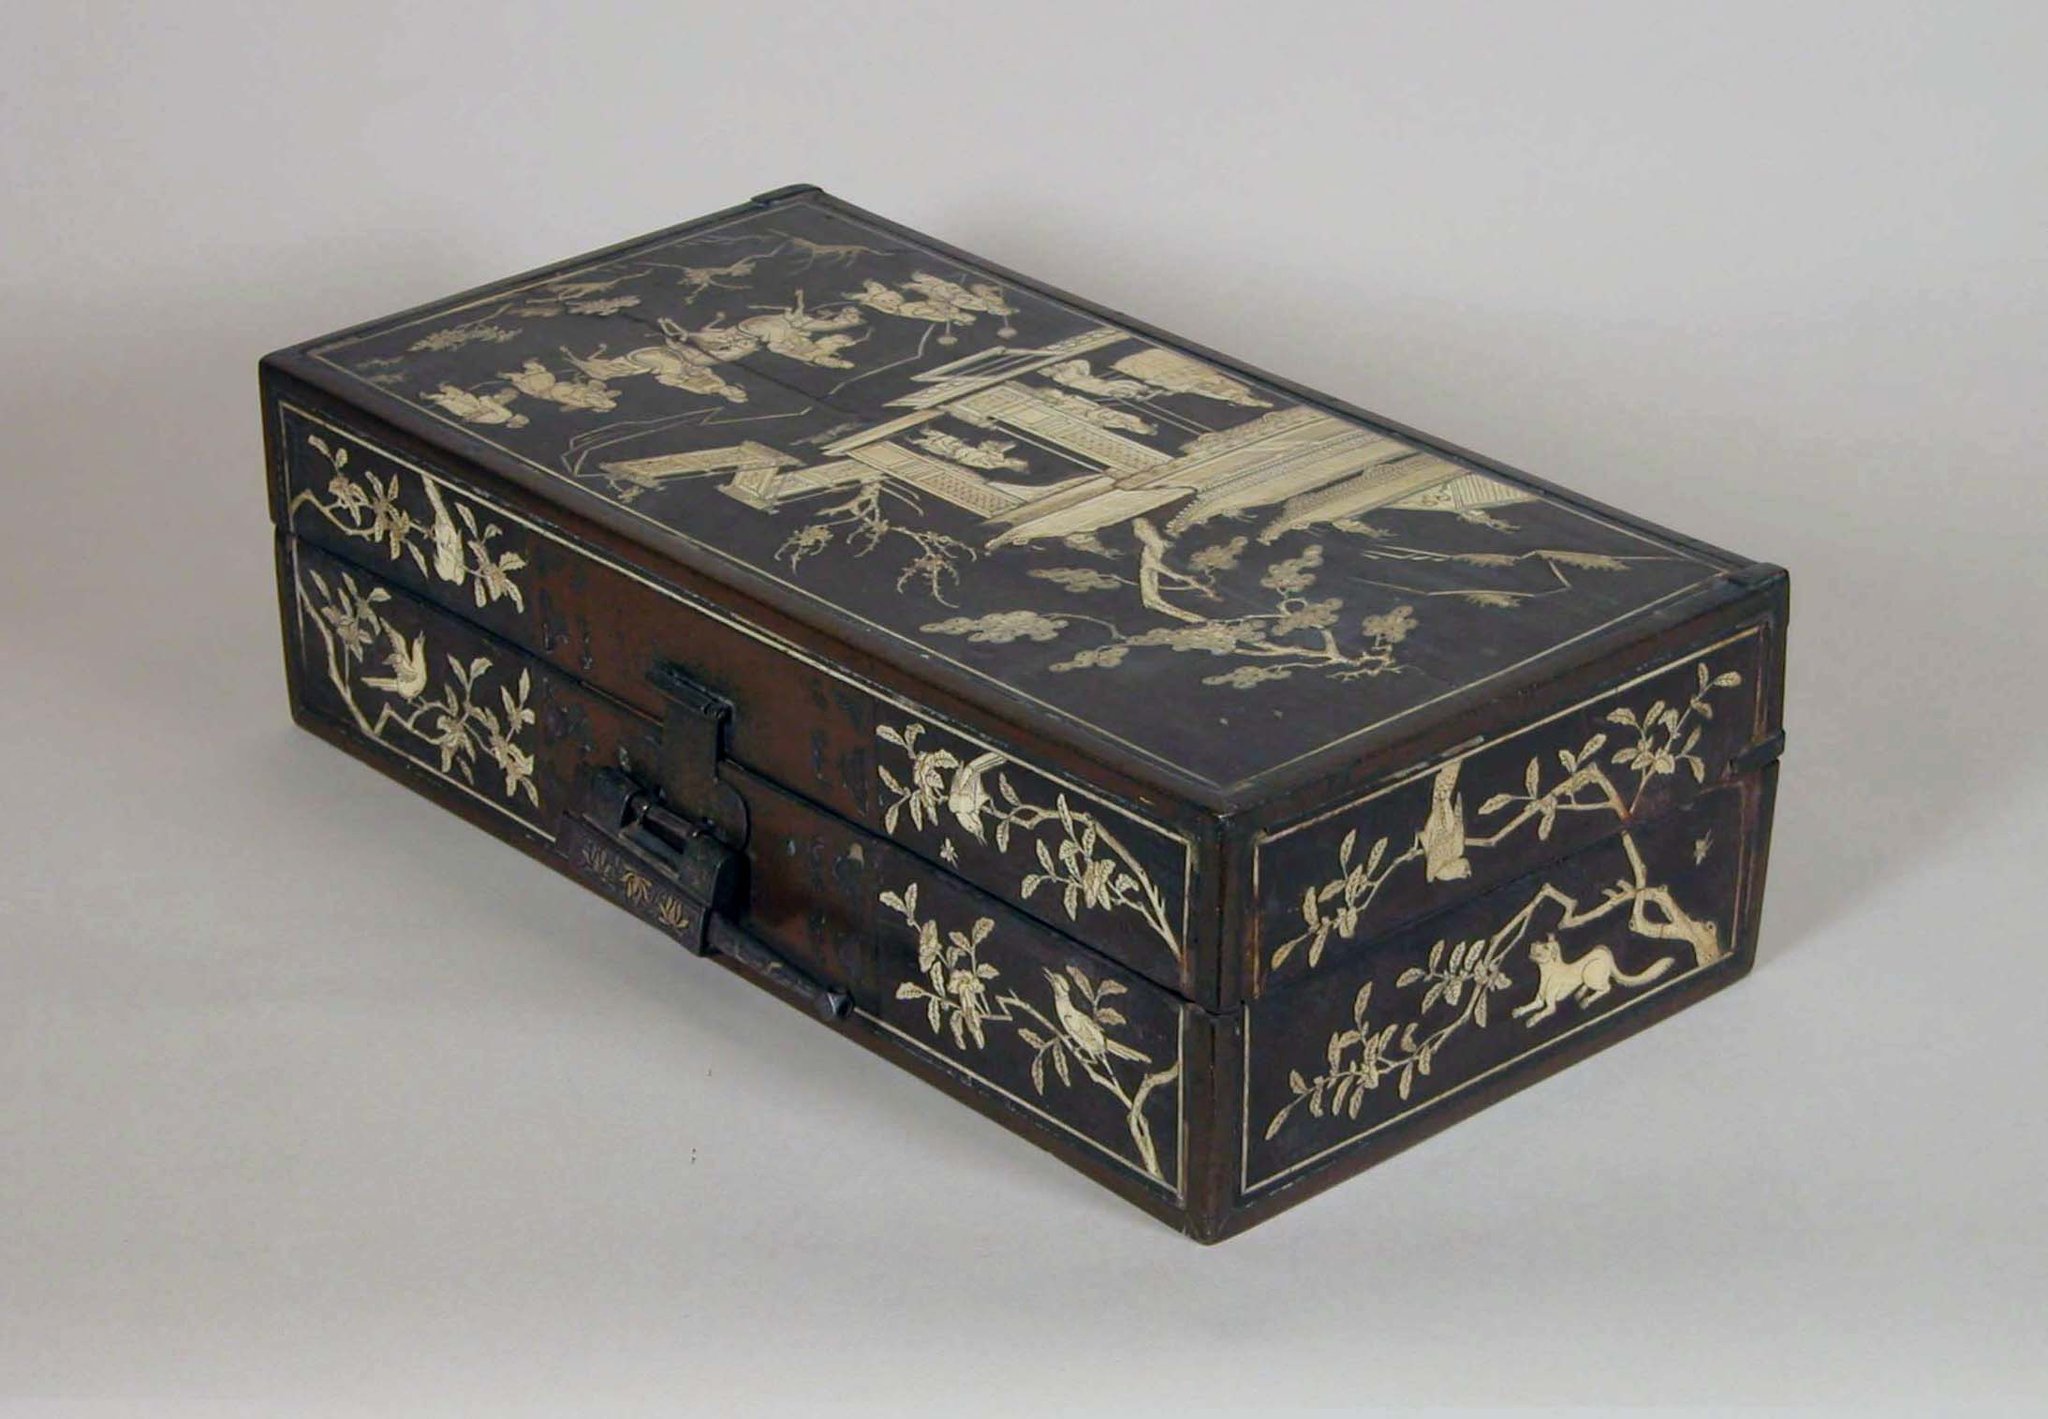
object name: box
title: Box with Scene of a Visit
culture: chinese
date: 1601-1700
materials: ivory, wood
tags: birds,horses